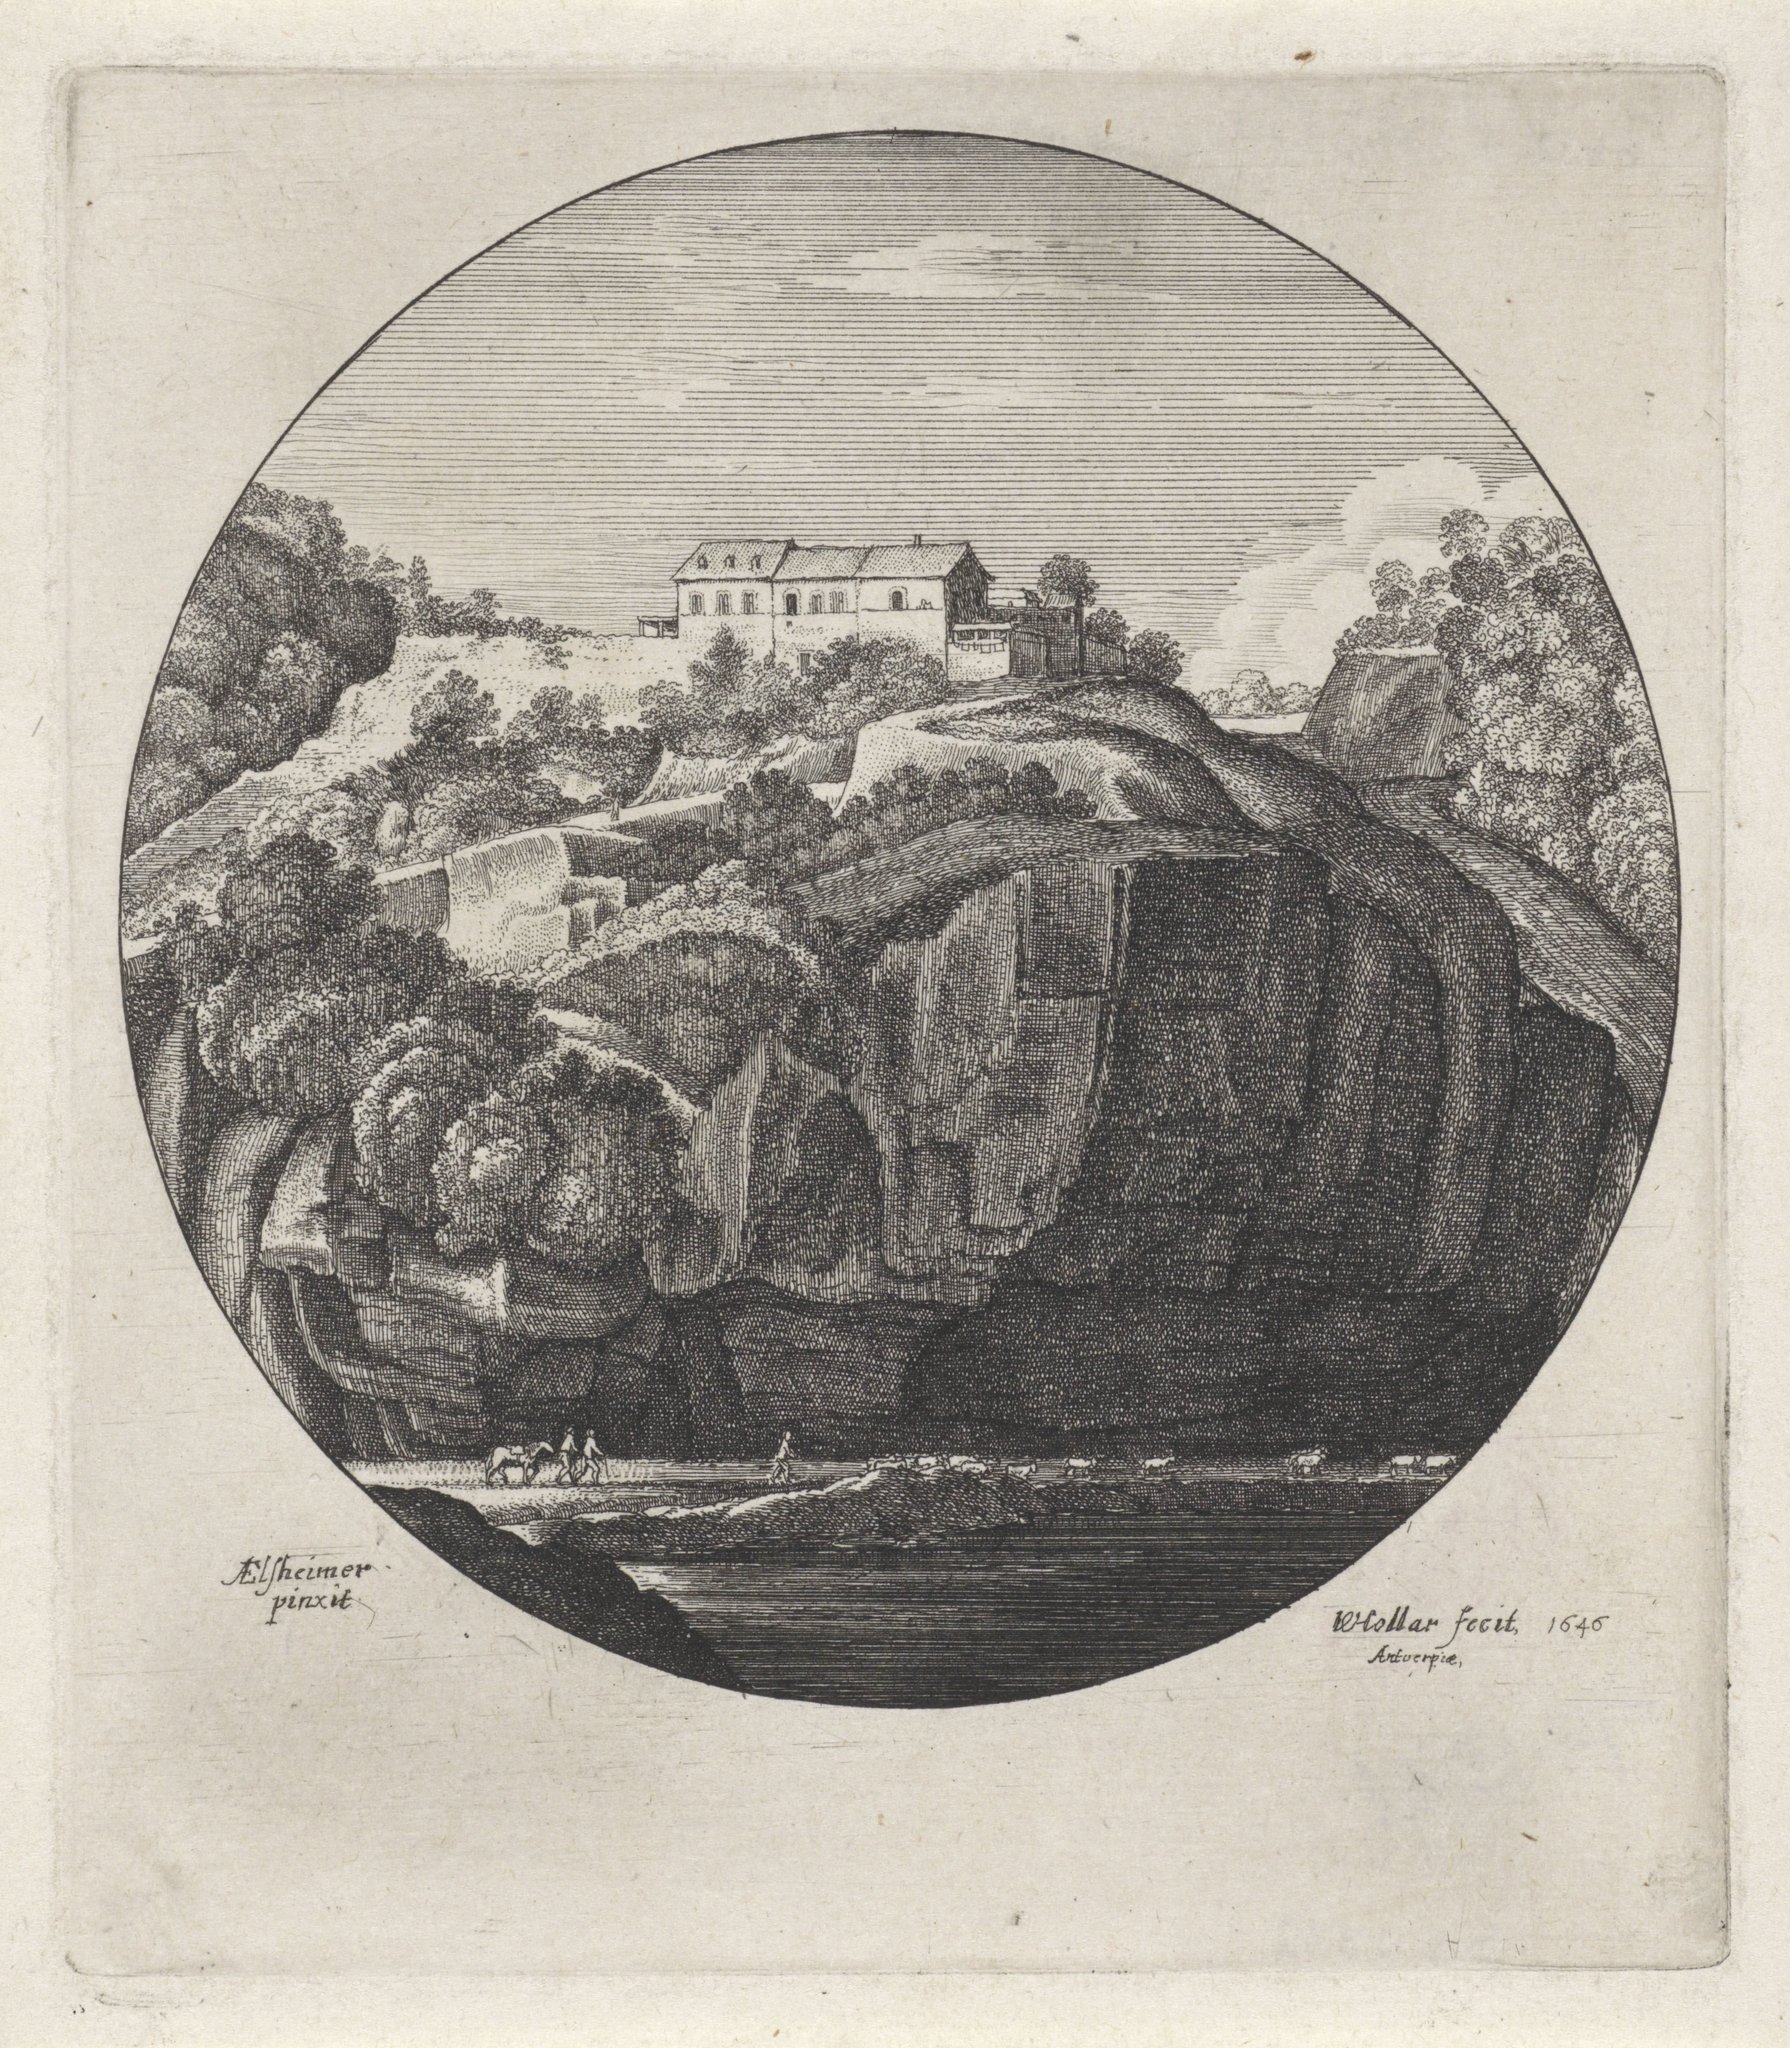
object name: print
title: Landschap met huis bij steile rotsen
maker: wenceslaus hollar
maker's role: draughtsman, print maker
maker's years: 1607-1677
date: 1646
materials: paper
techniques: etching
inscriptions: date